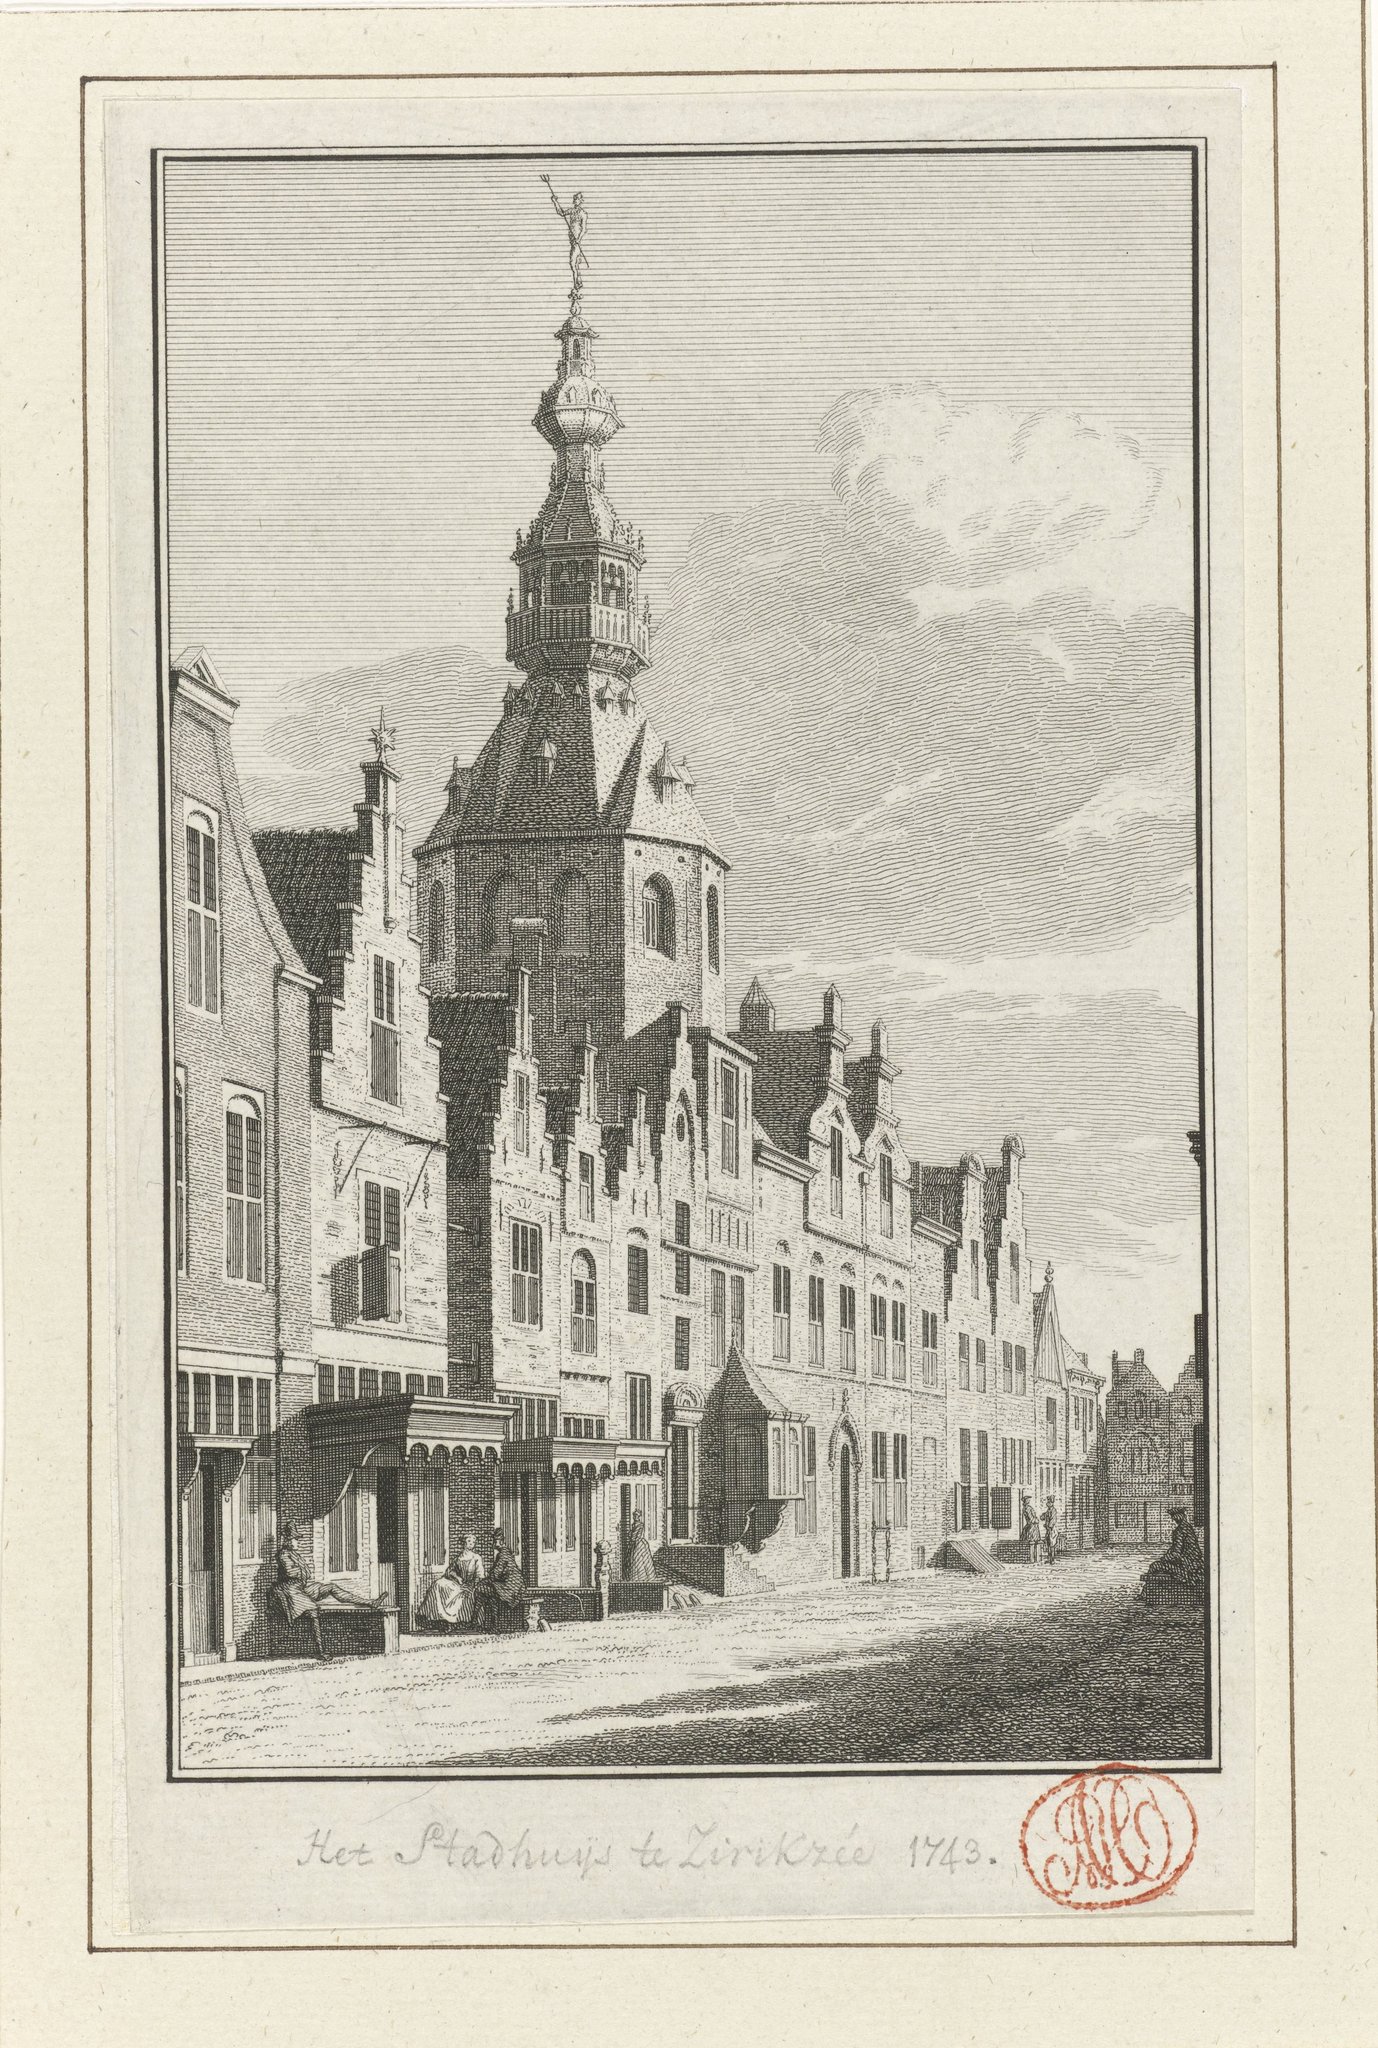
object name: print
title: Het stadhuijs te Zirikzée 1743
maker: jan caspar philips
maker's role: draughtsman, print maker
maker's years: 1700-1775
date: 1743-1747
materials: paper, pencil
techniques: engraving, etching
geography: amsterdam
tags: townhall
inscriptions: inscription: ‘Het stadhuijs te Zirikzée 1743’, collector's mark: Lugt 195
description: Gezicht op het stadhuis van Zierikzee, gelegen in de Meelstraat, in de situatie omstreeks 1743.